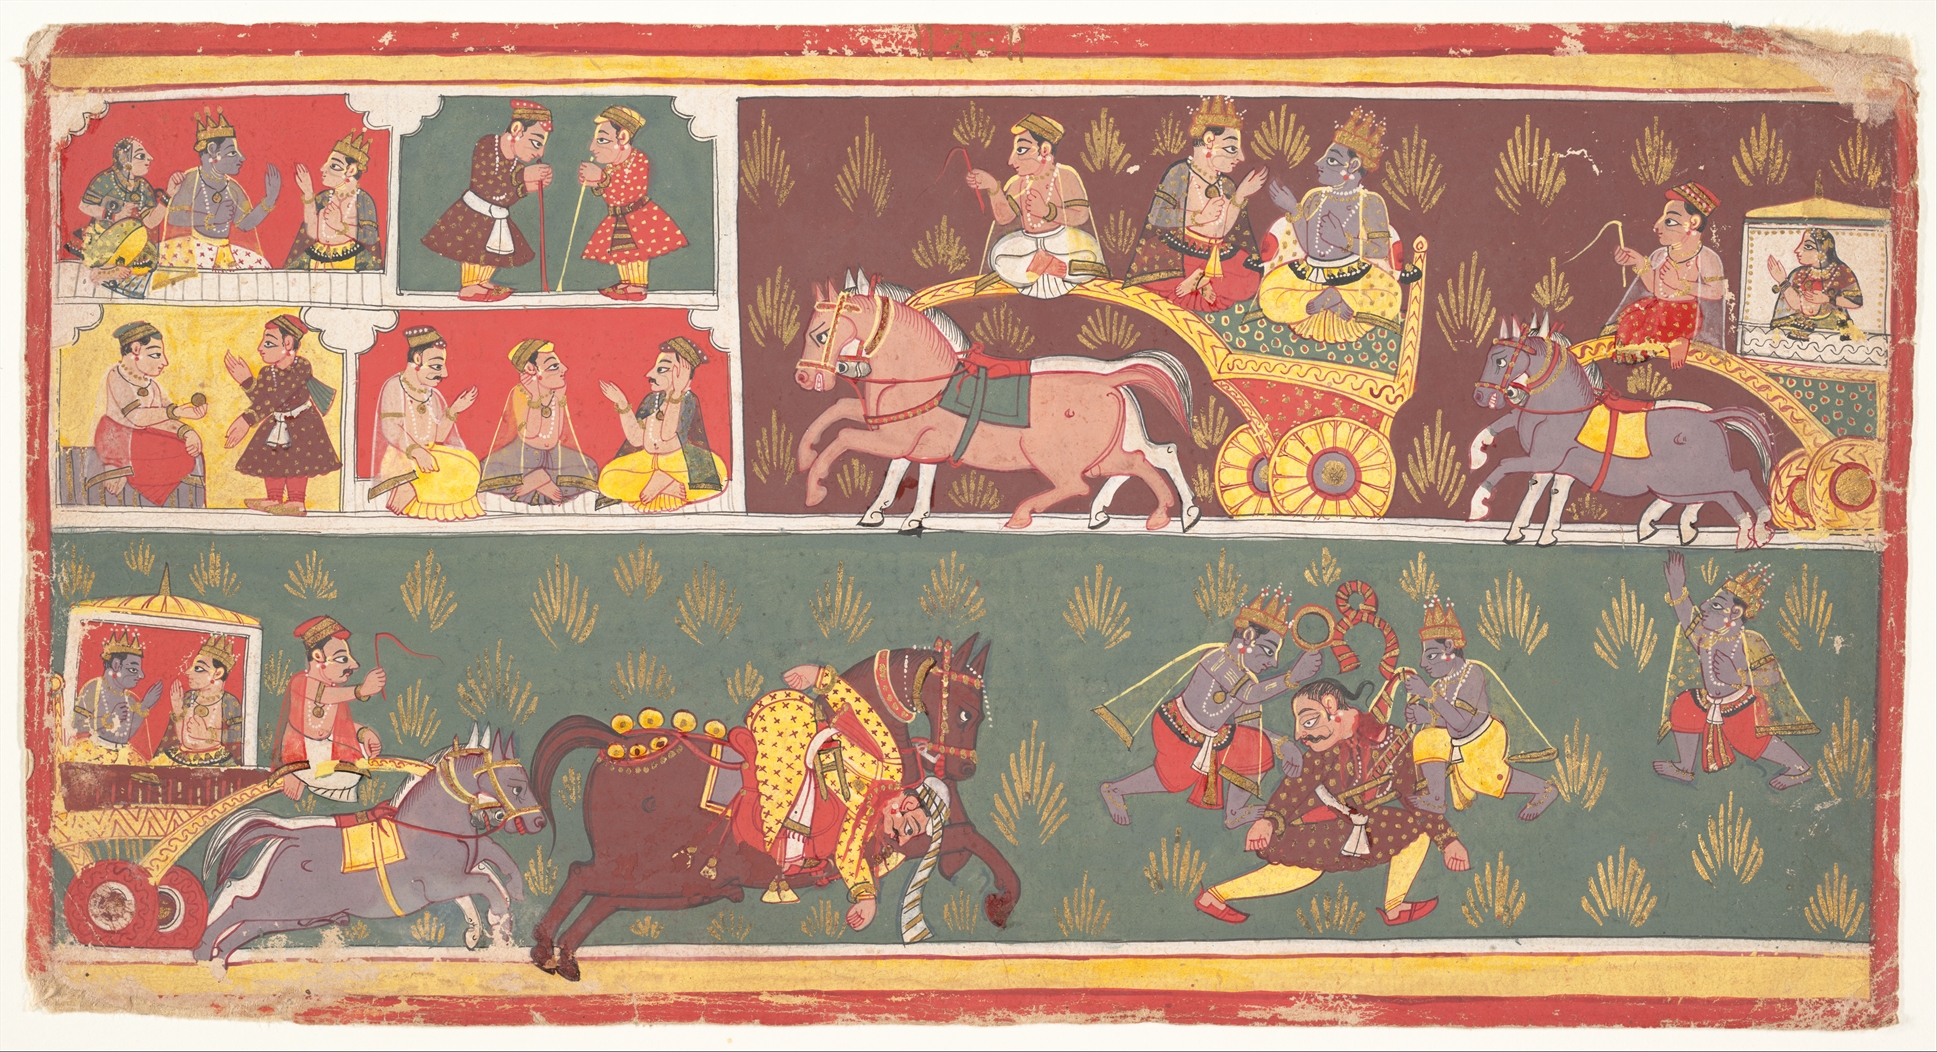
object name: folio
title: Episodes from Krishna's Life: Folio from a Bhagavata Purana (Ancient Stories of Lord Vishnu)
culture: indian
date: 1700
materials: ink, paper, watercolor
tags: men,women,horses,krishna,hinduism,chariots